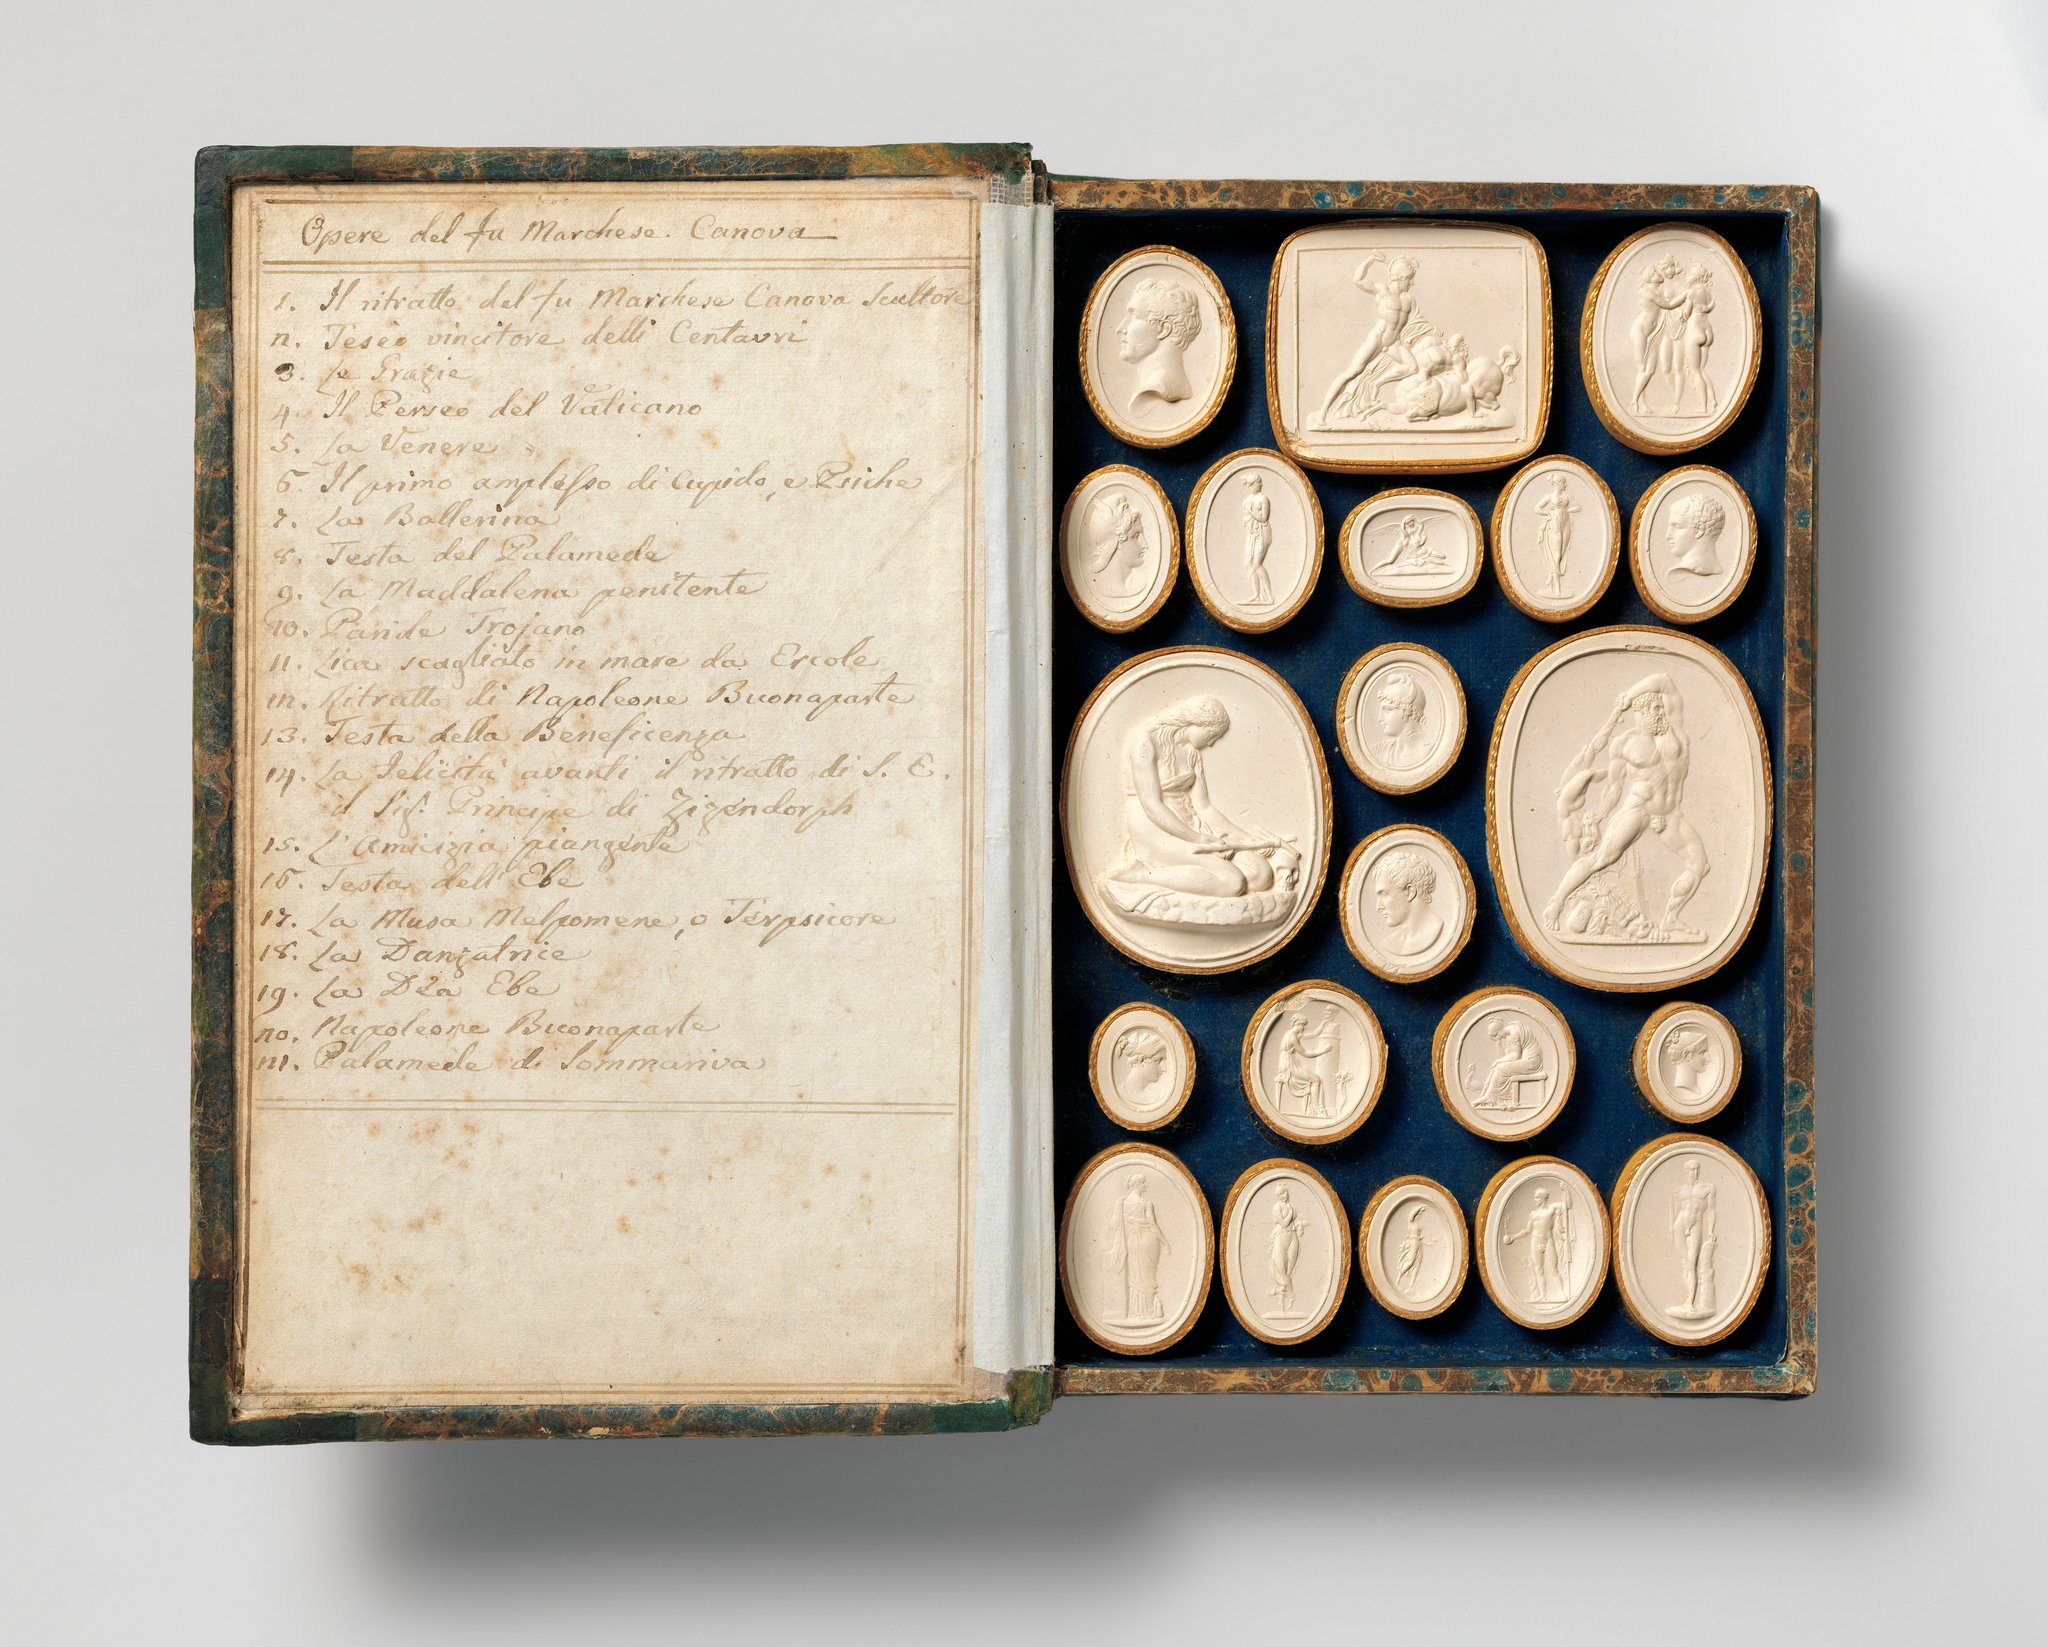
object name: box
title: Impressions of intaglios after the statuary of Canova and Thorvaldsen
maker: francesco carnesecchi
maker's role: artist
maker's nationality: italian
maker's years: 1800-1900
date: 1822-1844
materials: gesso, leather, paper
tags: male nudes,profiles,women